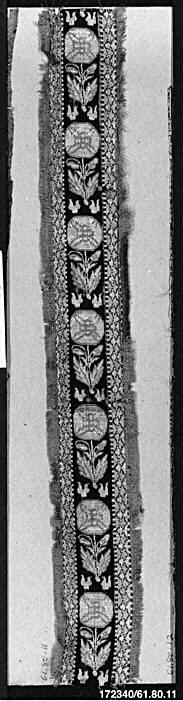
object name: band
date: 1601-1800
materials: metal thread, silk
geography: iran